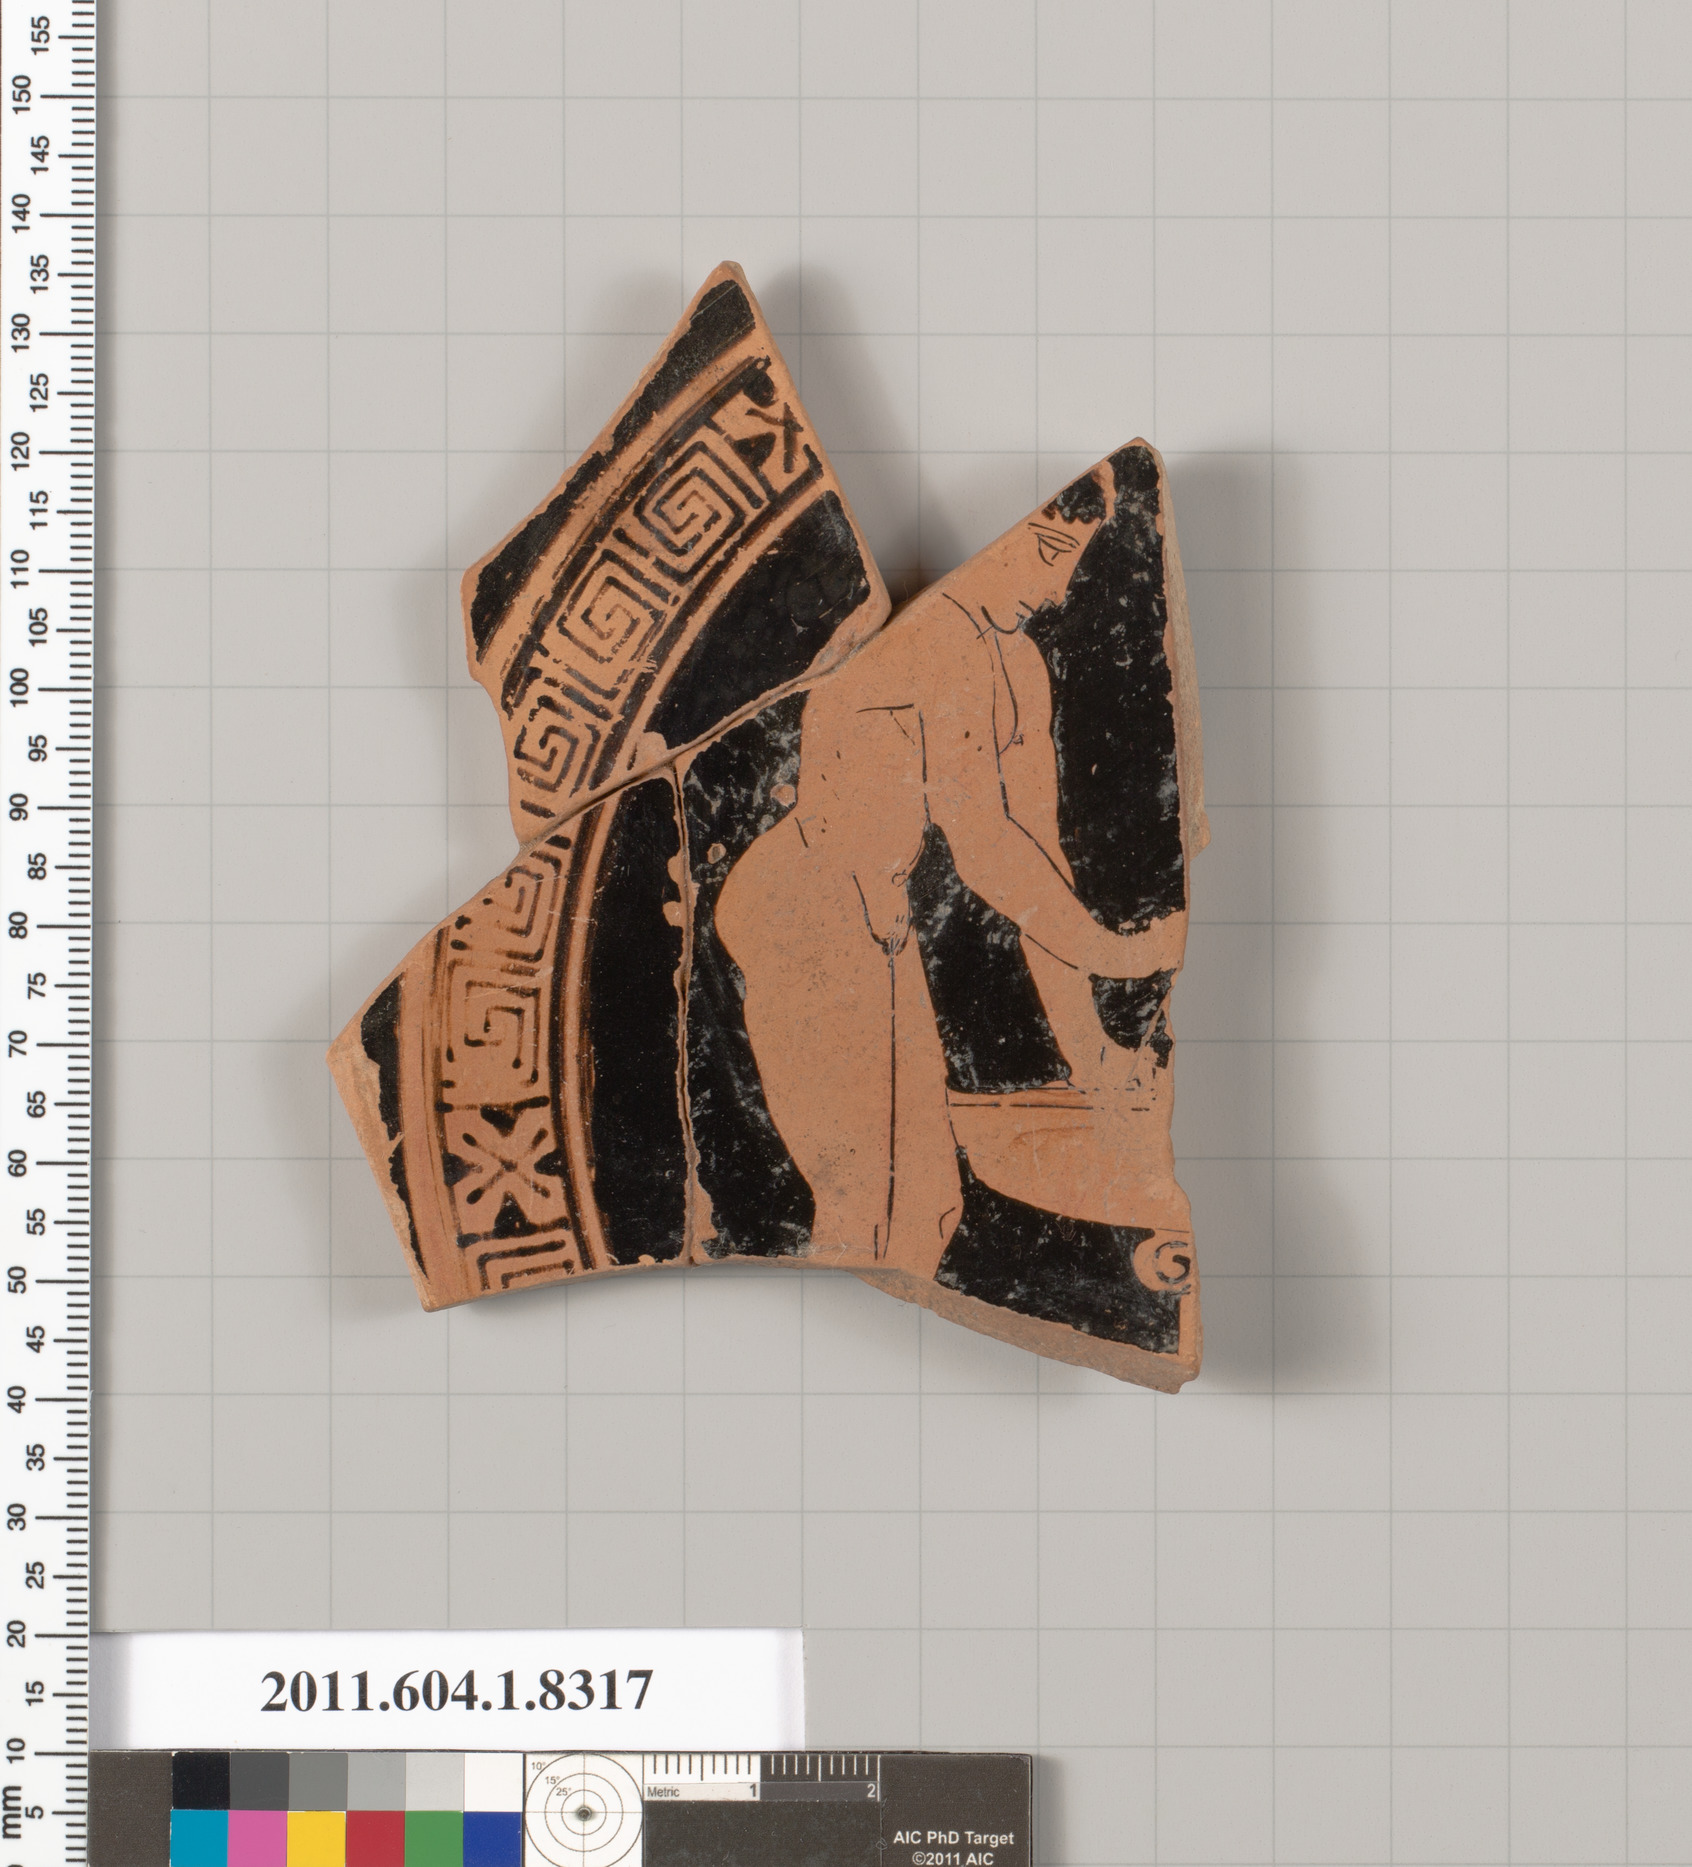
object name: kylix fragment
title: Terracotta fragment of a kylix (drinking cup)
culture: greek, attic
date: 450-426 BCE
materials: terracotta